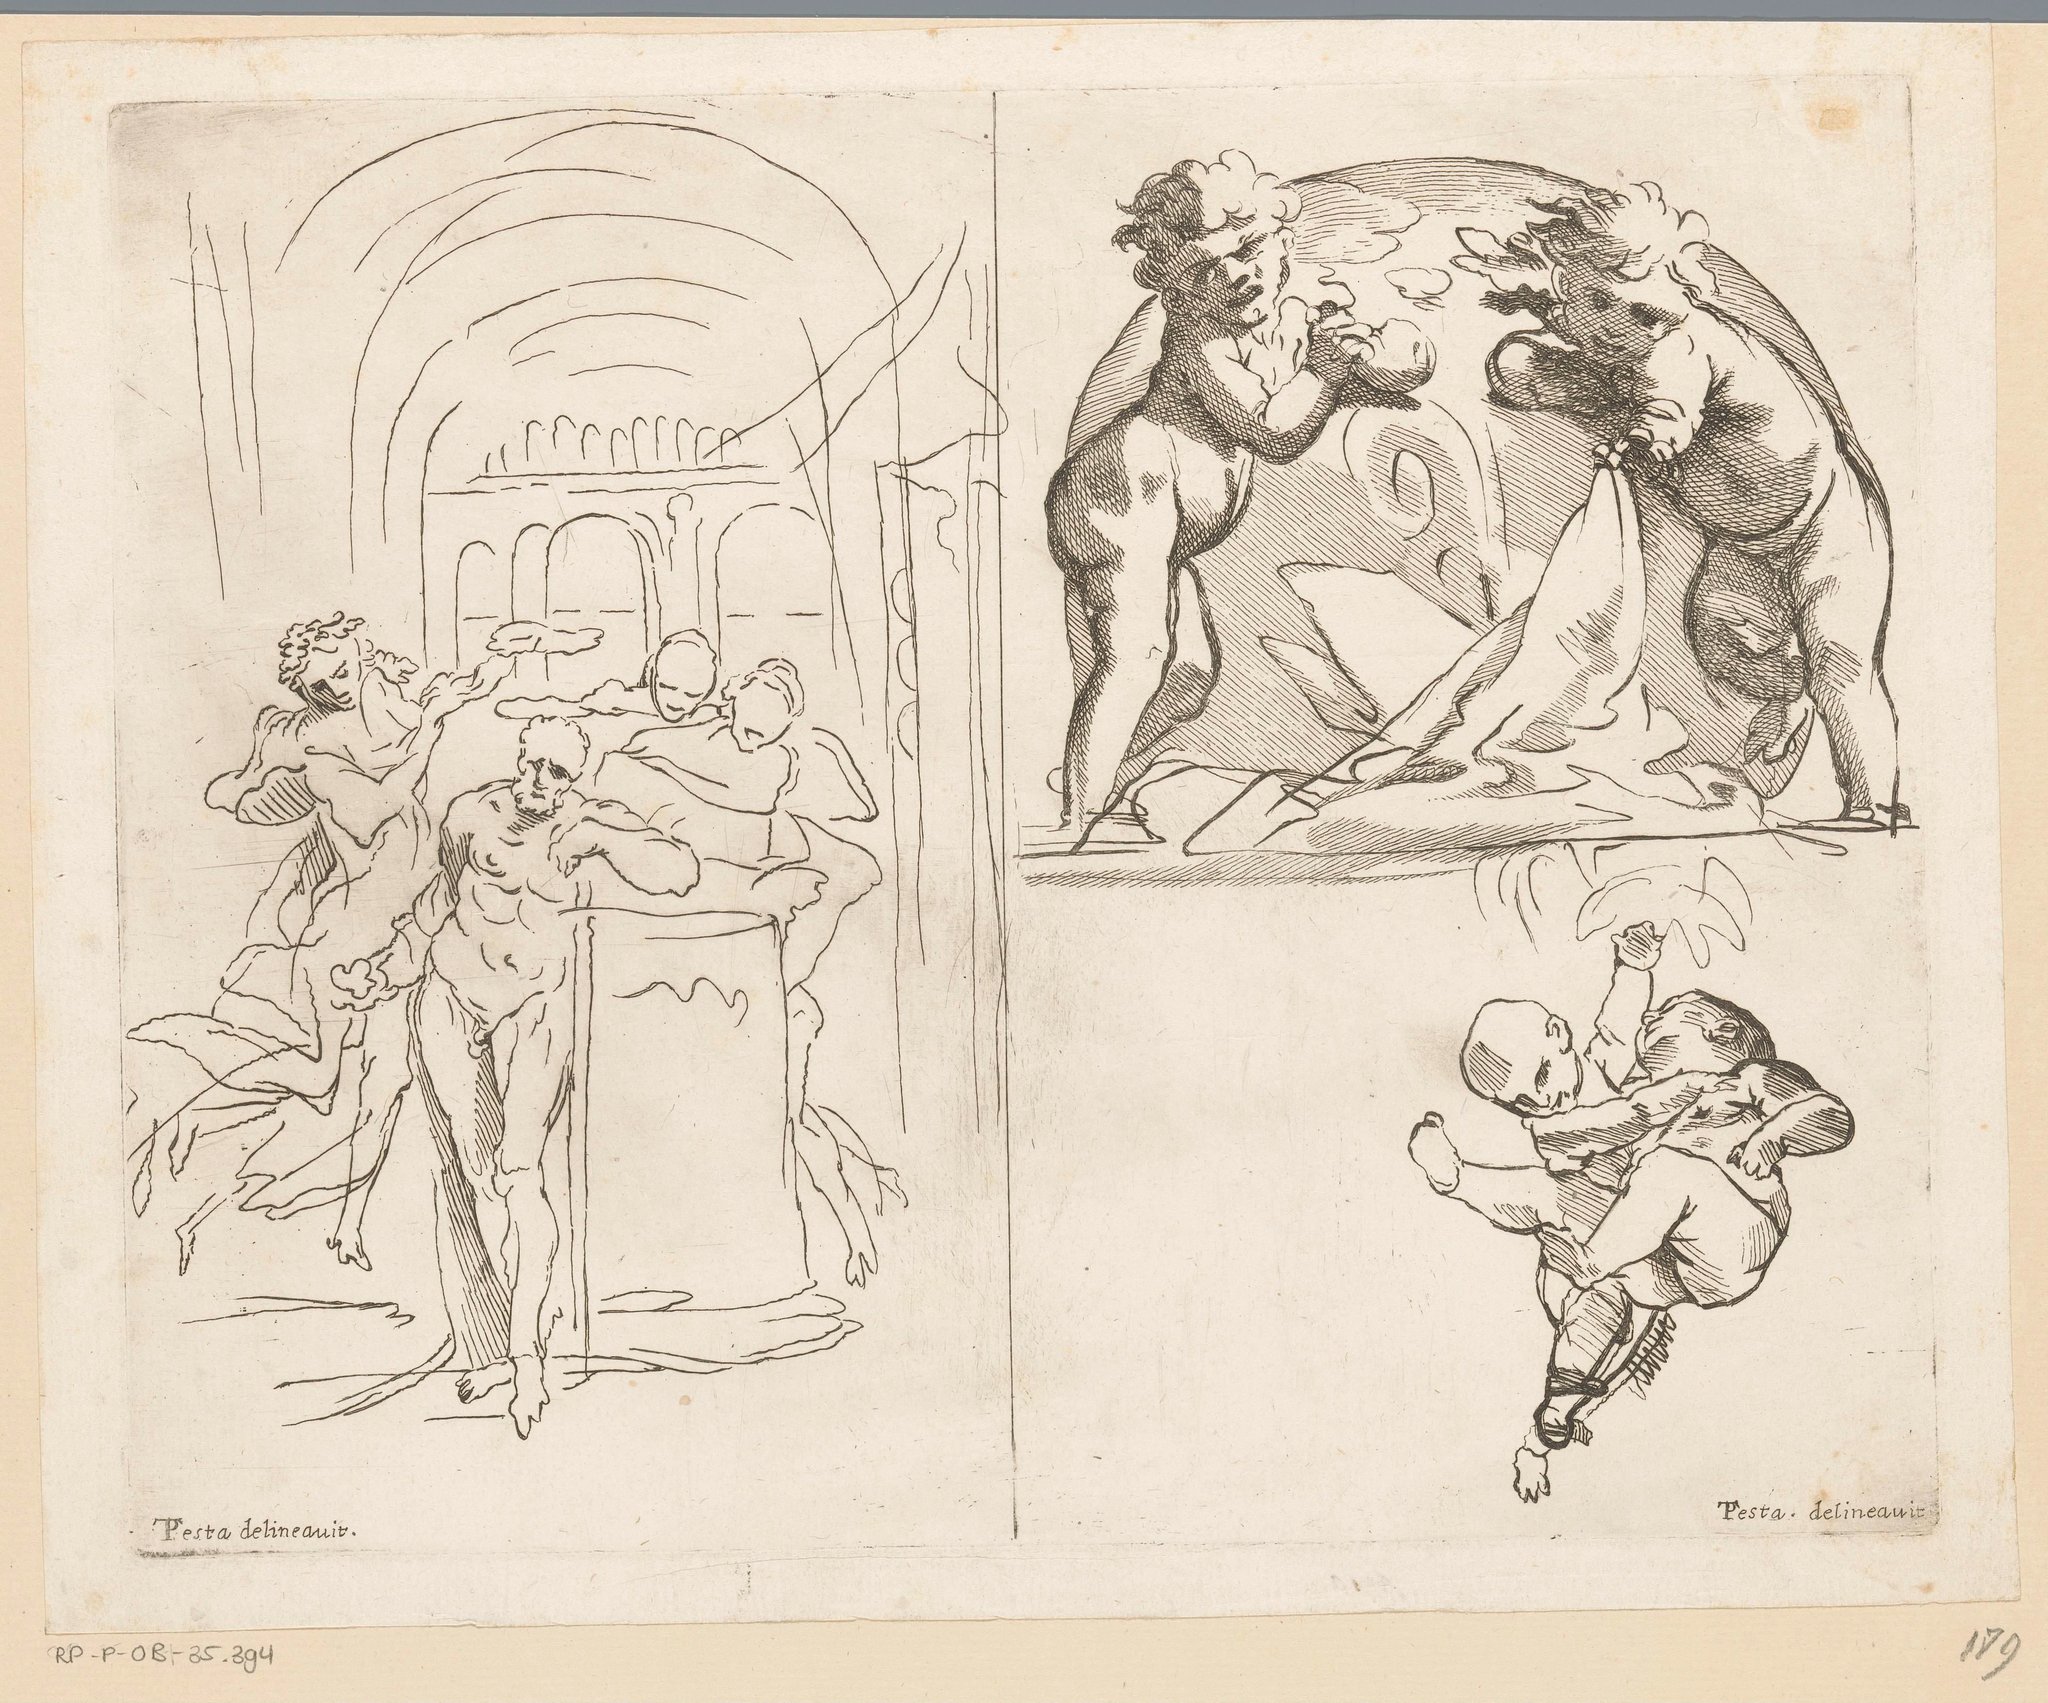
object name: print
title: Naakte oude man bij altaar, putti en kinderen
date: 1650-1750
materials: paper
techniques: etching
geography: italy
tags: toddler, old man, altar, cupids: 'amores', 'amoretti', 'putti', angels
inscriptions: collector's mark: Lugt 240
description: Blad met drie voorstellingen. Links een naakte oude man bij een altaar. Hij wordt gekroond door drie engelen. Rechtsboven twee putti. Rechtsonder twee buitelende kinderen.